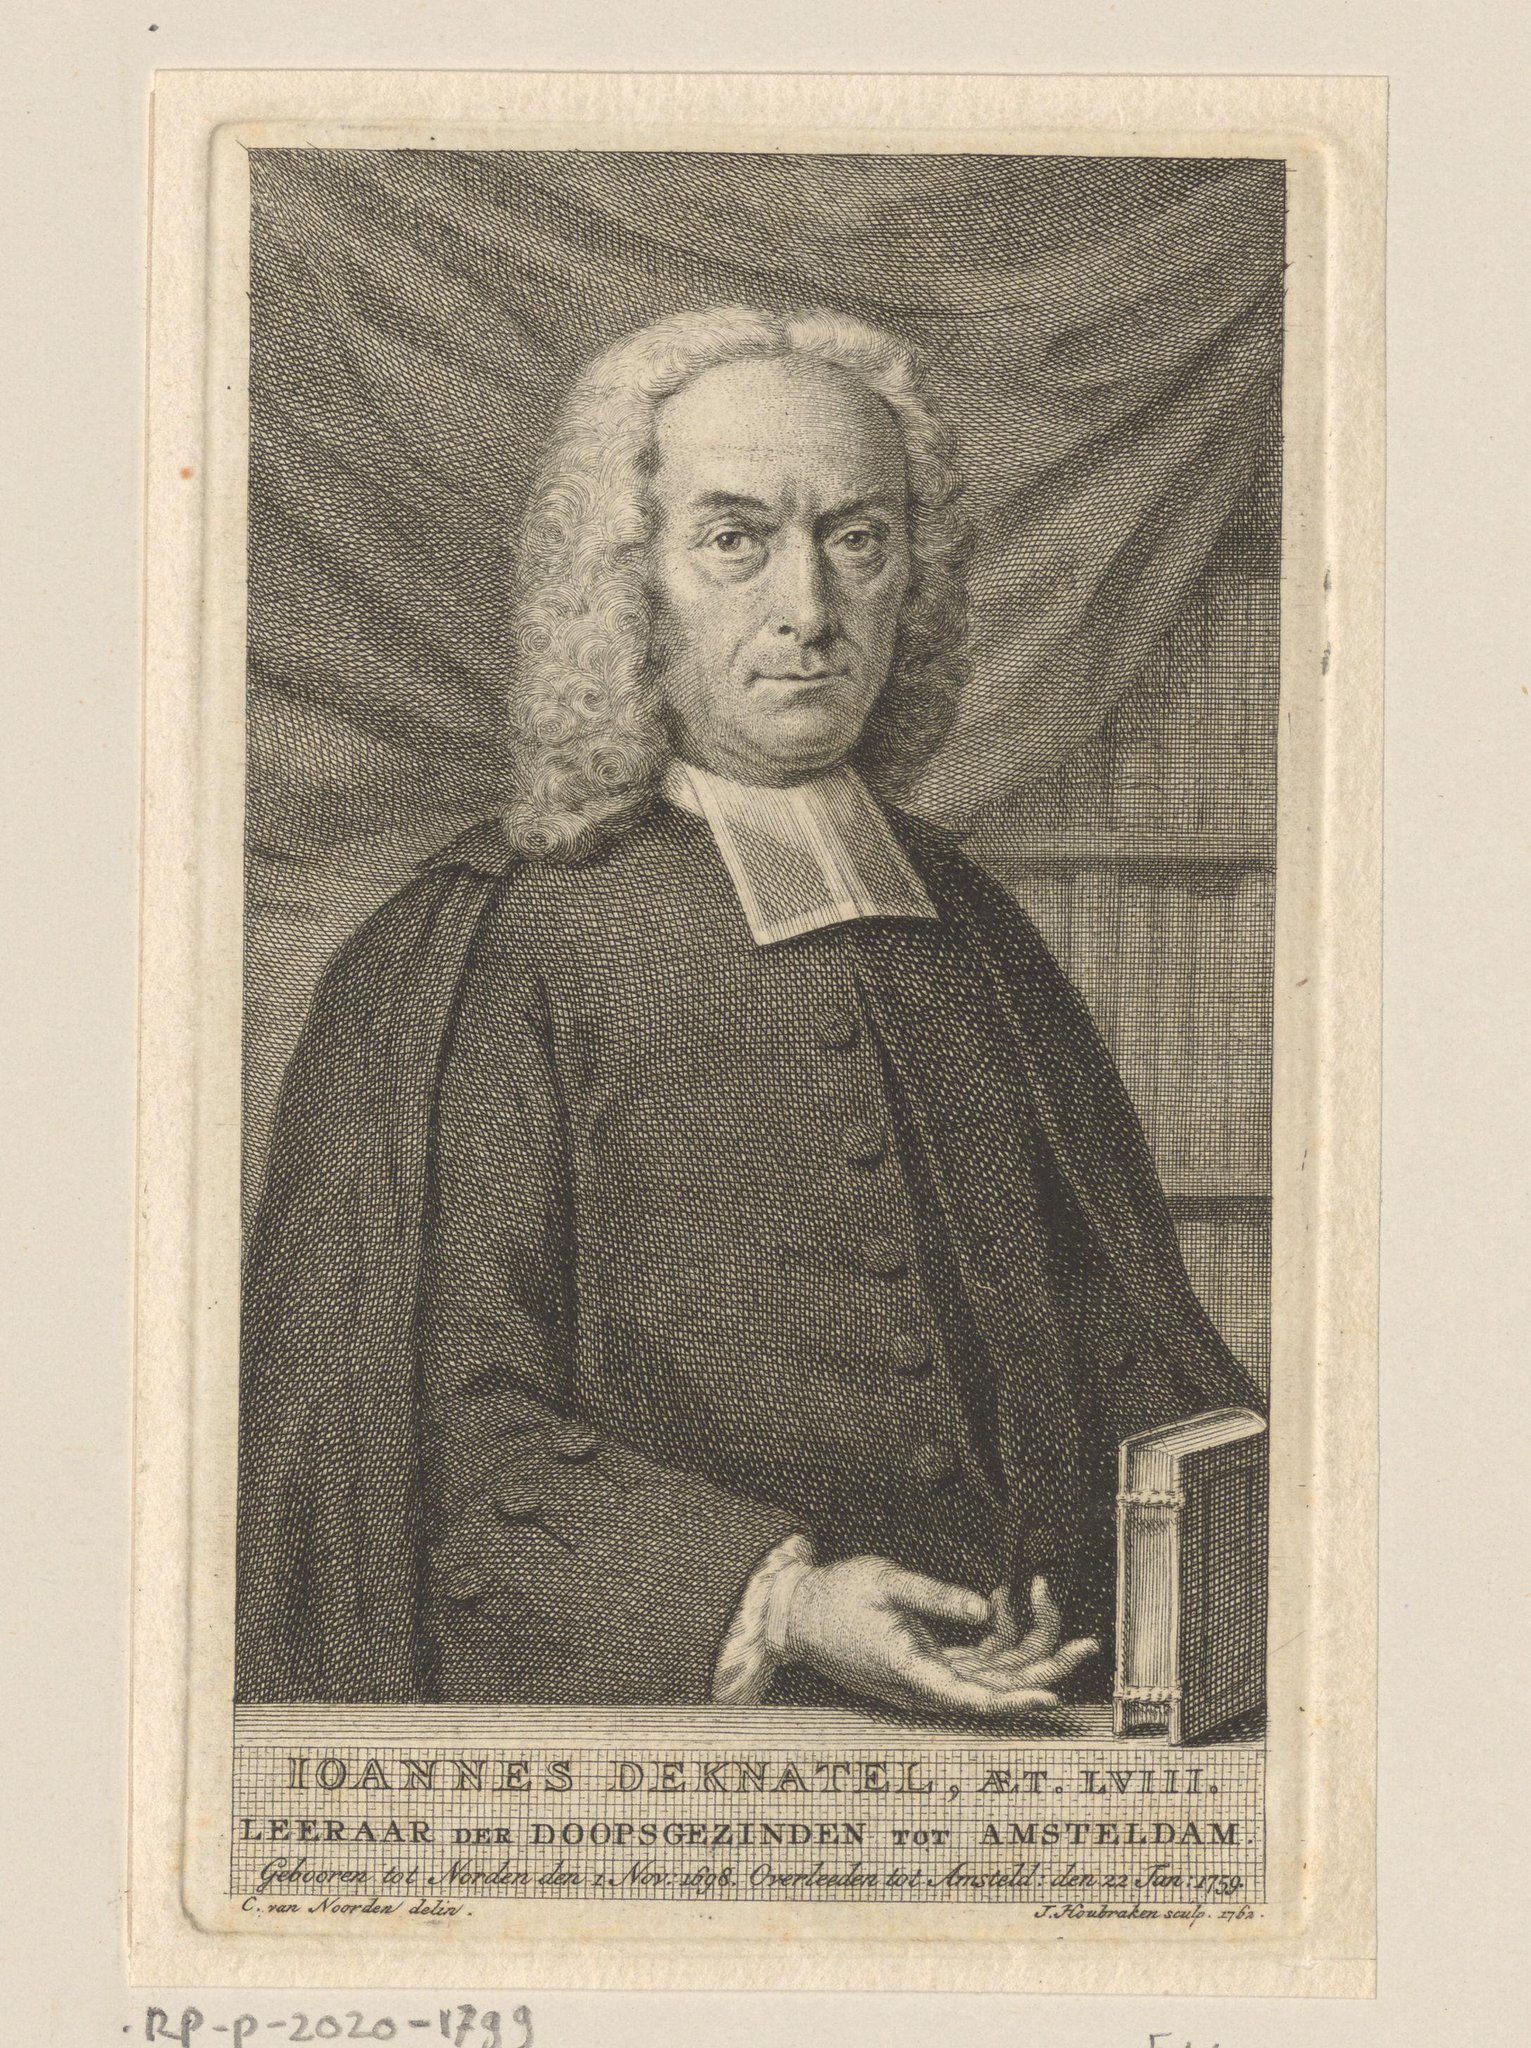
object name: print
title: Portret van Joannes Deknatel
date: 1762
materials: paper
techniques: engraving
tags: amsterdam, theologian, historical persons, portrait of a writer